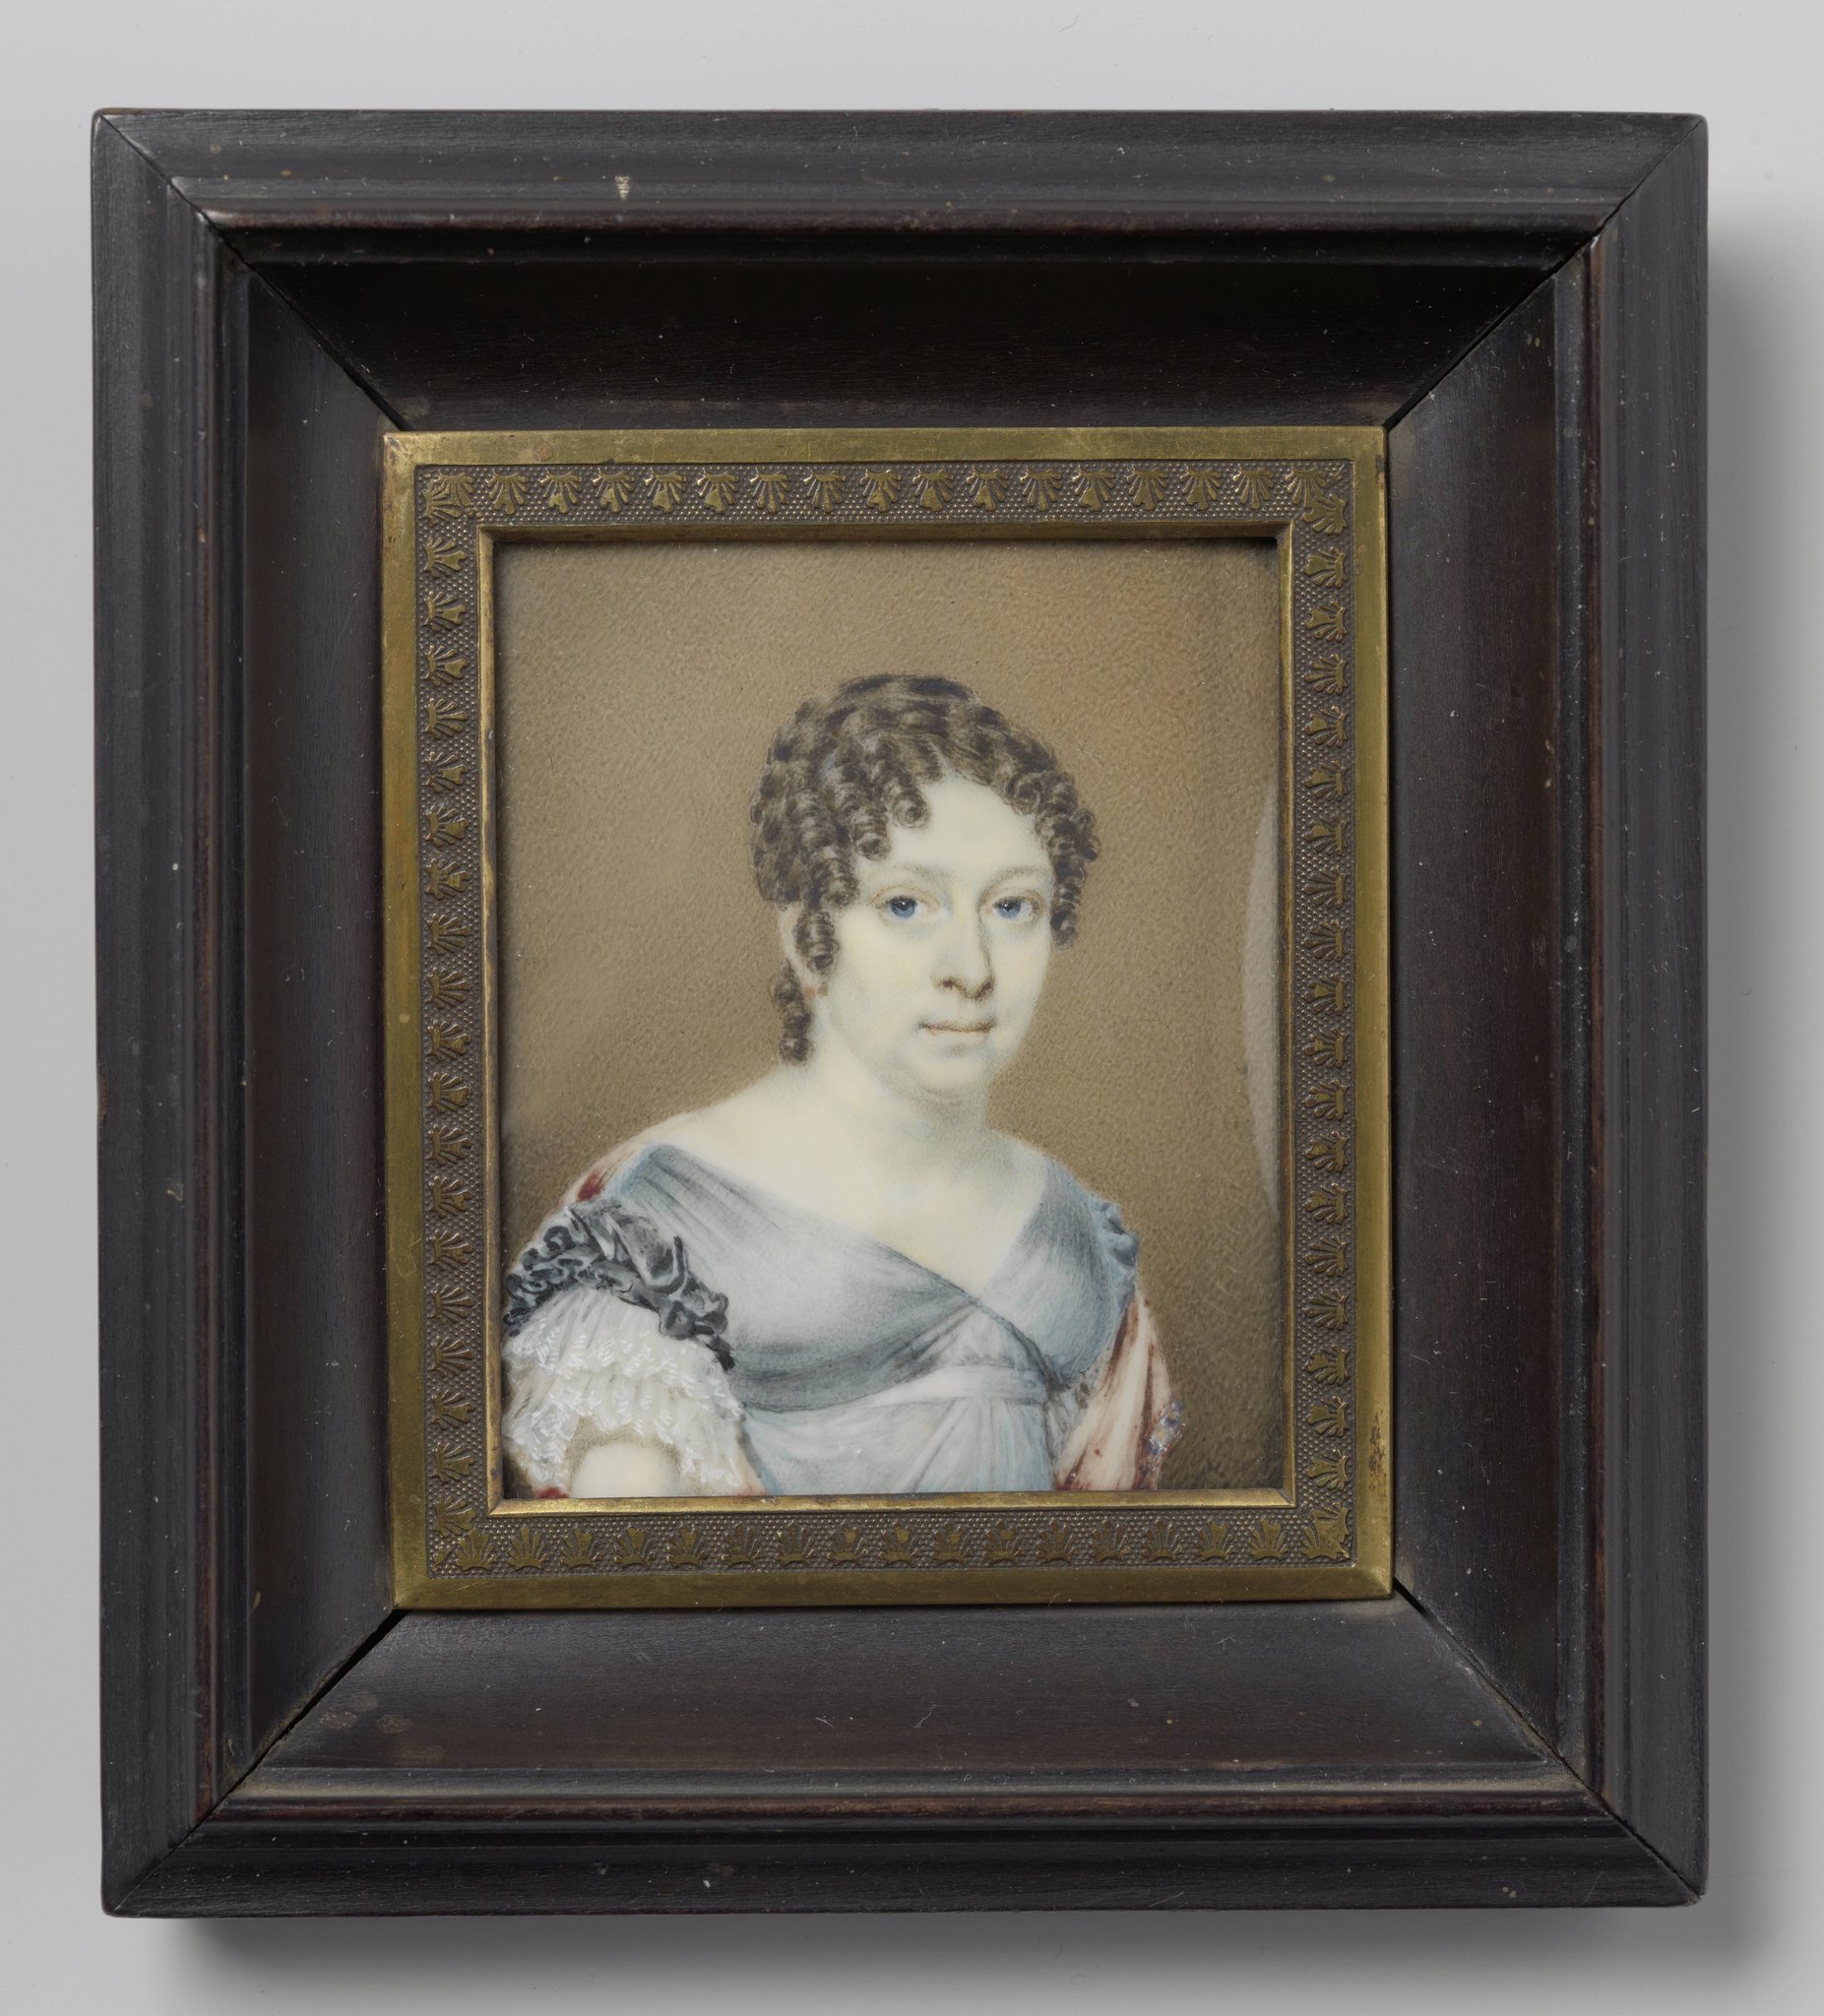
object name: painting, miniature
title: Portrait of a Woman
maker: joseph charles de haen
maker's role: draughtsman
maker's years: 1777-1836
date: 1790-1836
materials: cardboard, glass, ivory, metal, watercolor, wood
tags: historical persons not known by name - bb - woman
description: Portret van een vrouw. Buste, naar rechts. Onderdeel van de collectie portretminiaturen.